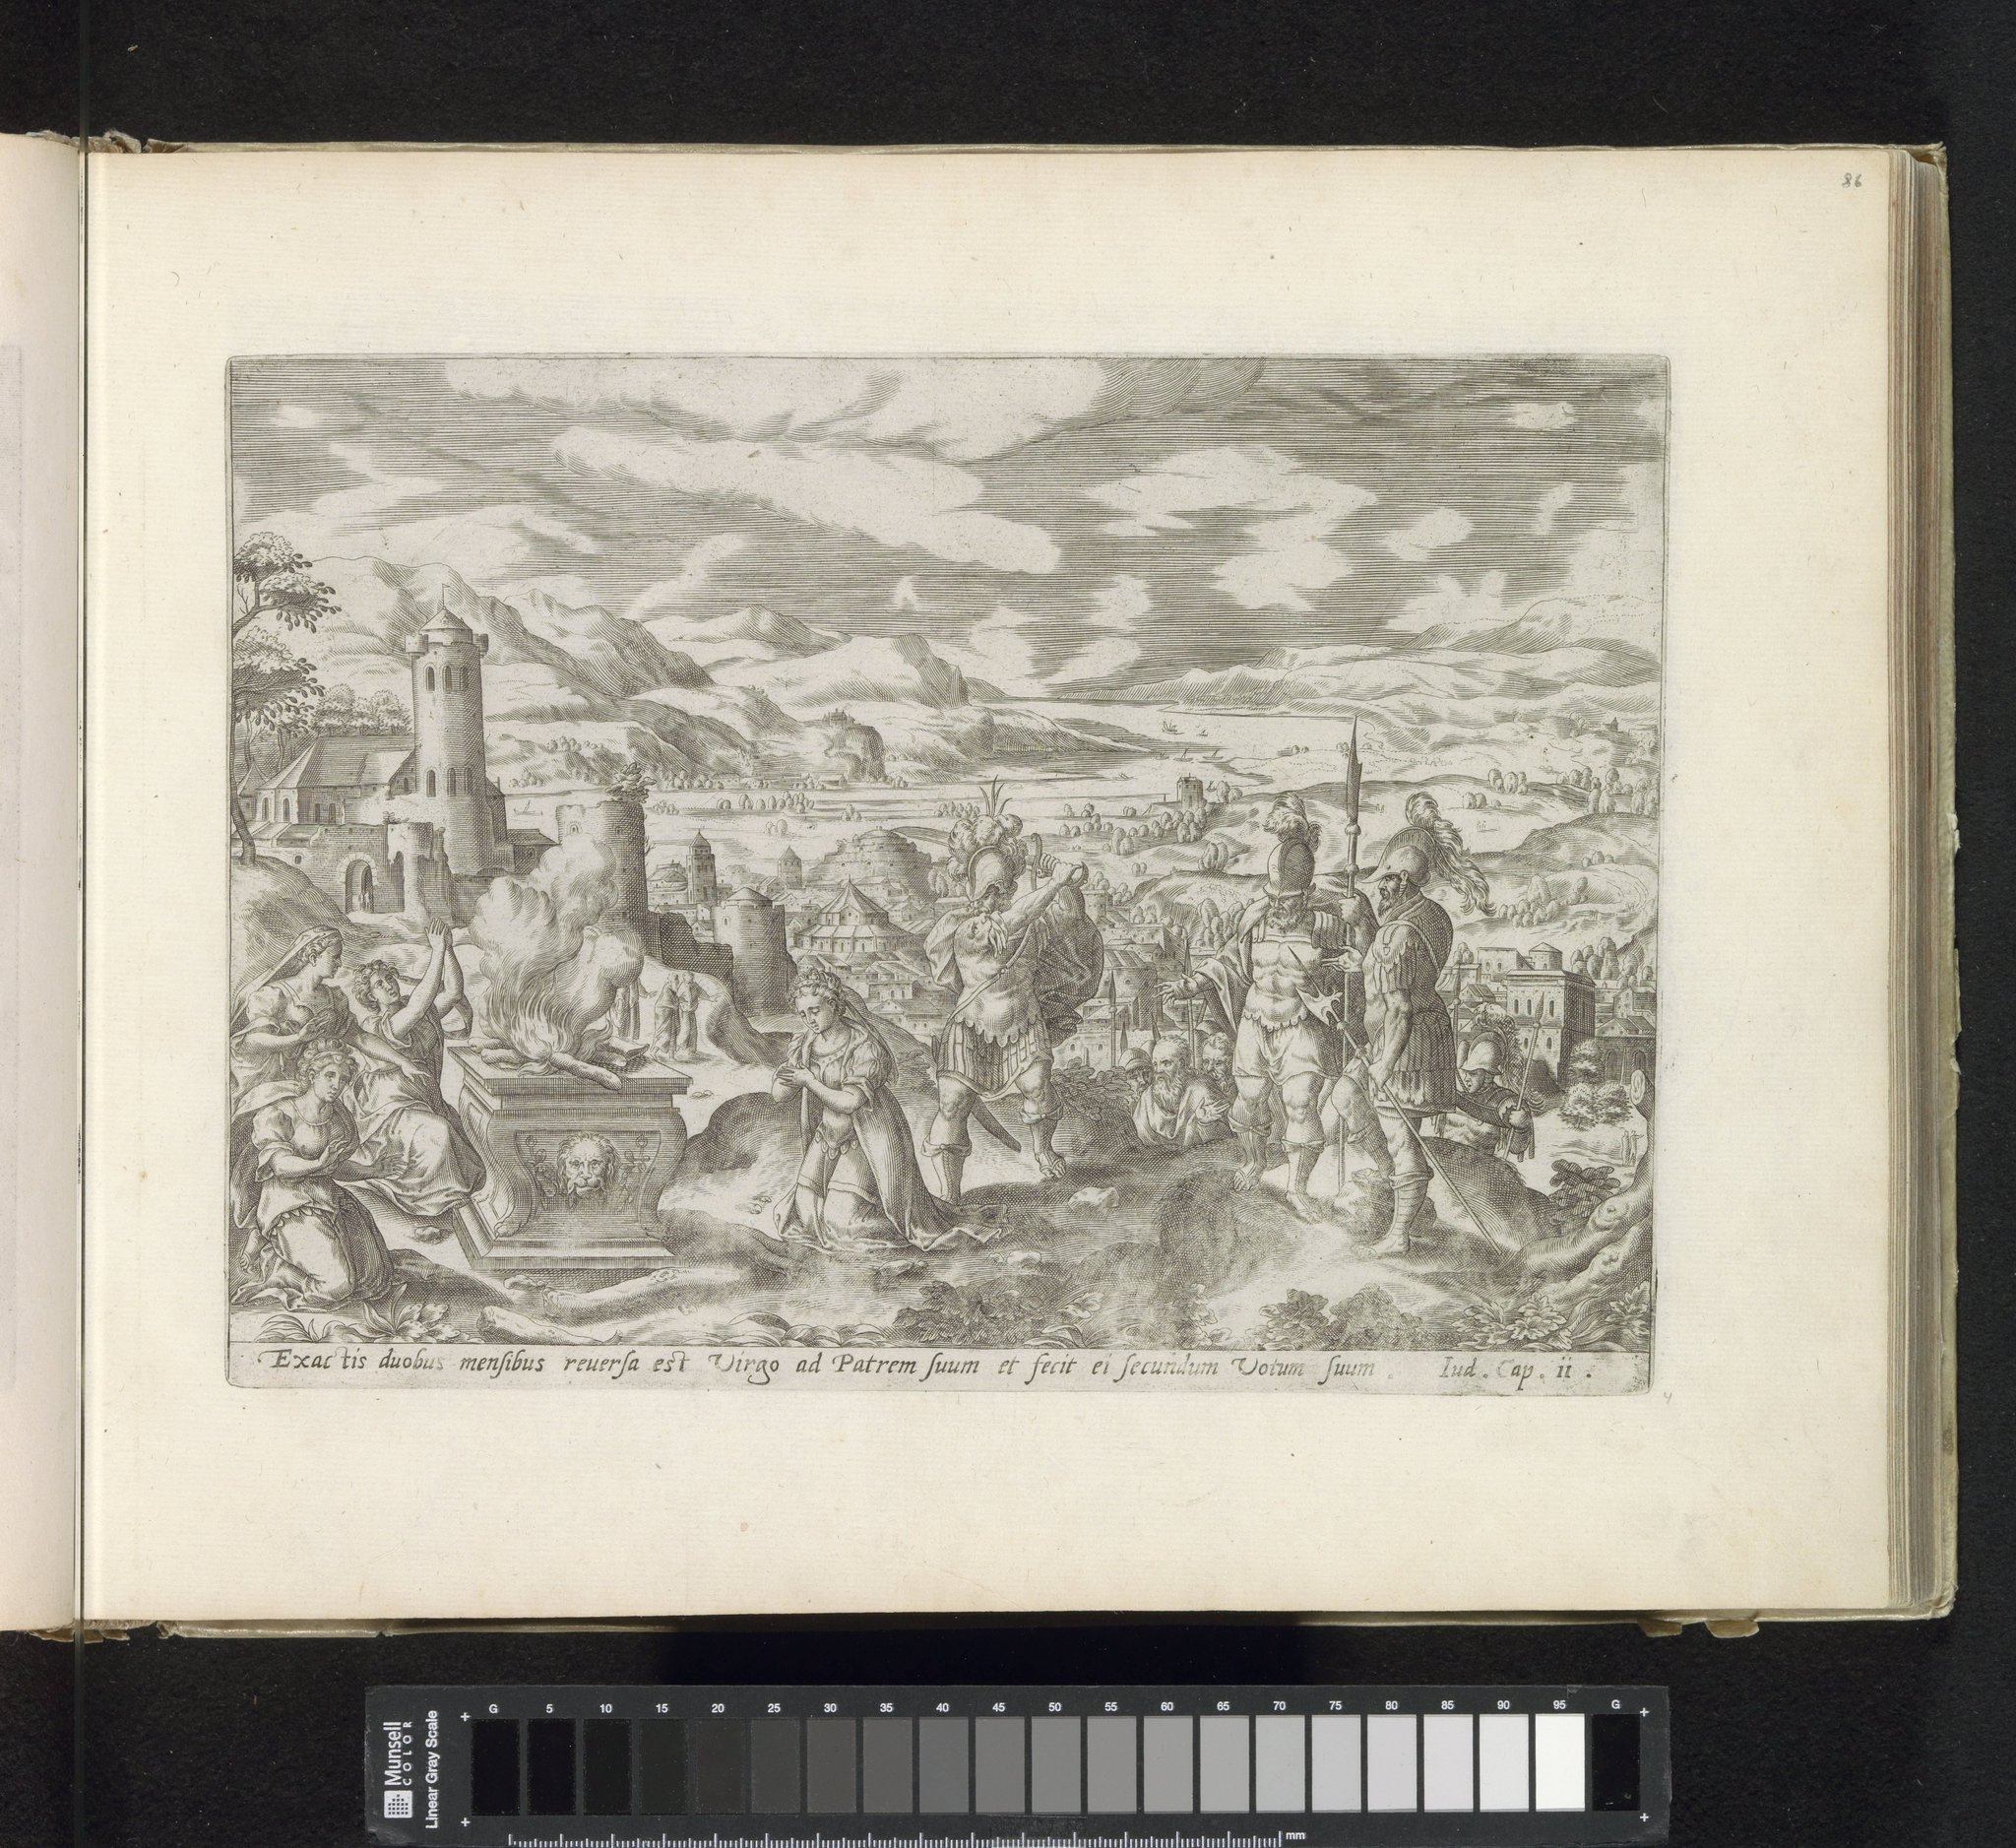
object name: album leaf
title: Jefta offert zijn dochter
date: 1585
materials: paper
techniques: engraving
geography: antwerp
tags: fulfilment of jephthah's vow to the lord: jephthah's daughter is sacrificed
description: Jefta heft zijn zwaard om zijn dochter te doden en te offeren. De dochter knielt bij het altaar. Links de weeklagende vriendinnen van Jefta's dochter. Rechts kijken soldaten toe. Op de achtergrond een stad in het landschap. Onder de voorstelling een verwijzing in het Latijn naar de Bijbeltekst in Ri. 11. Deze prent maakt deel uit van een album.